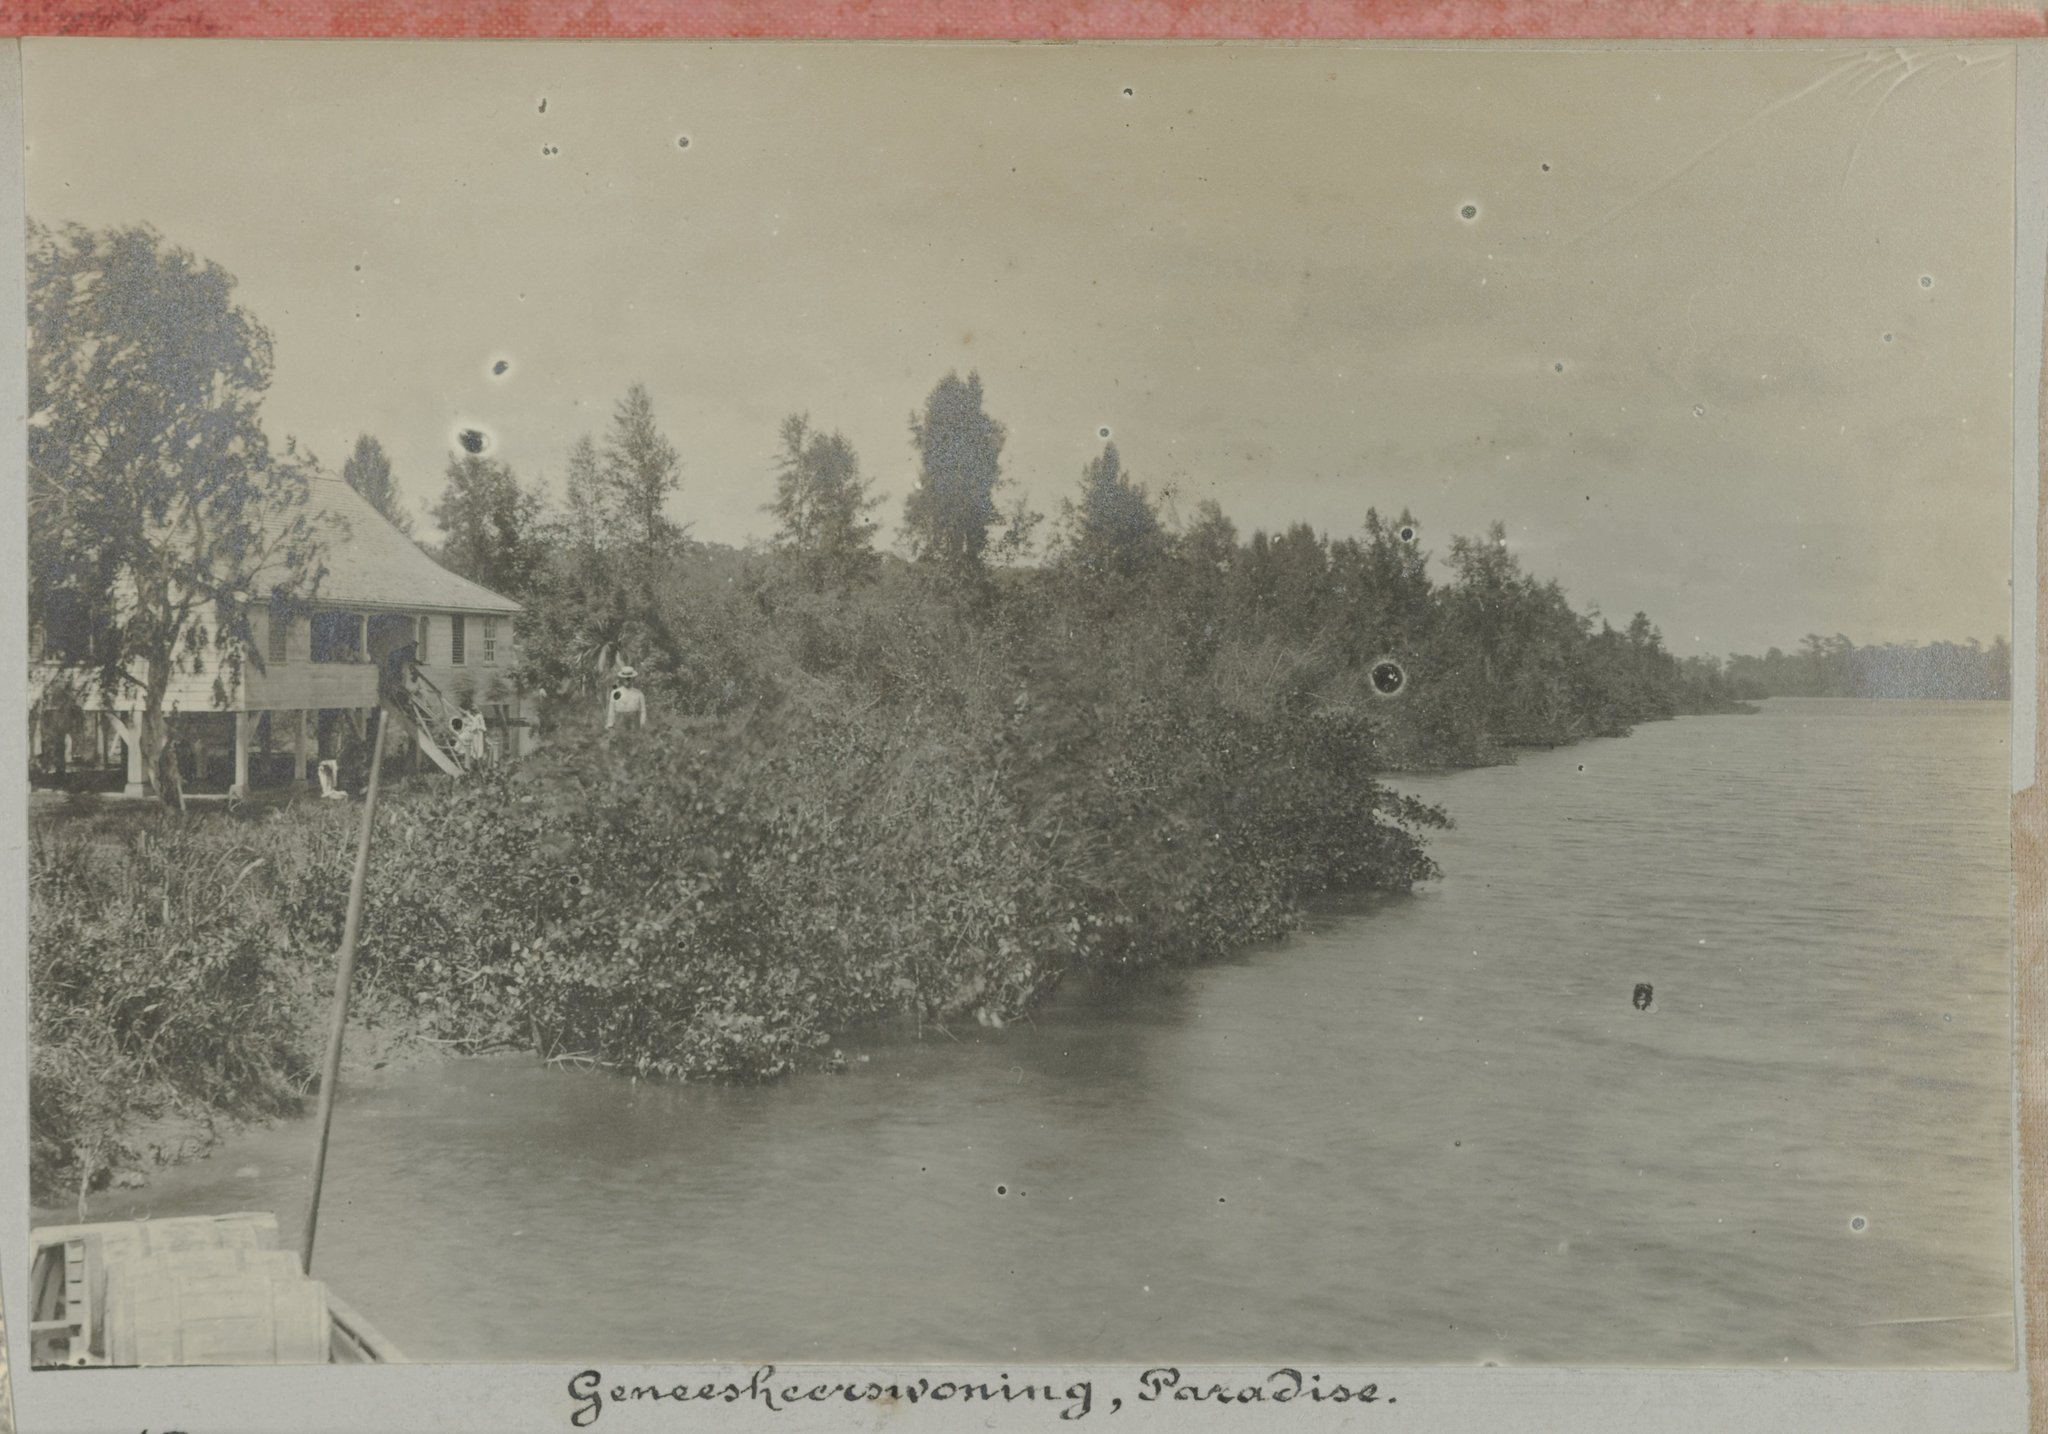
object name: photograph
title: Geneesheerswoning, Paradise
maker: gomez burke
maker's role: fotograaf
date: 1891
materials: photographic support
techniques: gelatin silver print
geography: suriname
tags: suriname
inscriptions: inscription: ‘G.B. / Geneesheerswoning, Paradise.’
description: Gezicht op de aan het water gelegen geneesheerswoning bij de Plantage Paradise. Onderdeel van het fotoalbum Souvenir de Voyage (deel 4), over het leven van de familie Dooyer in en rond de plantage Ma Retraite in Suriname in de jaren 1906-1913.